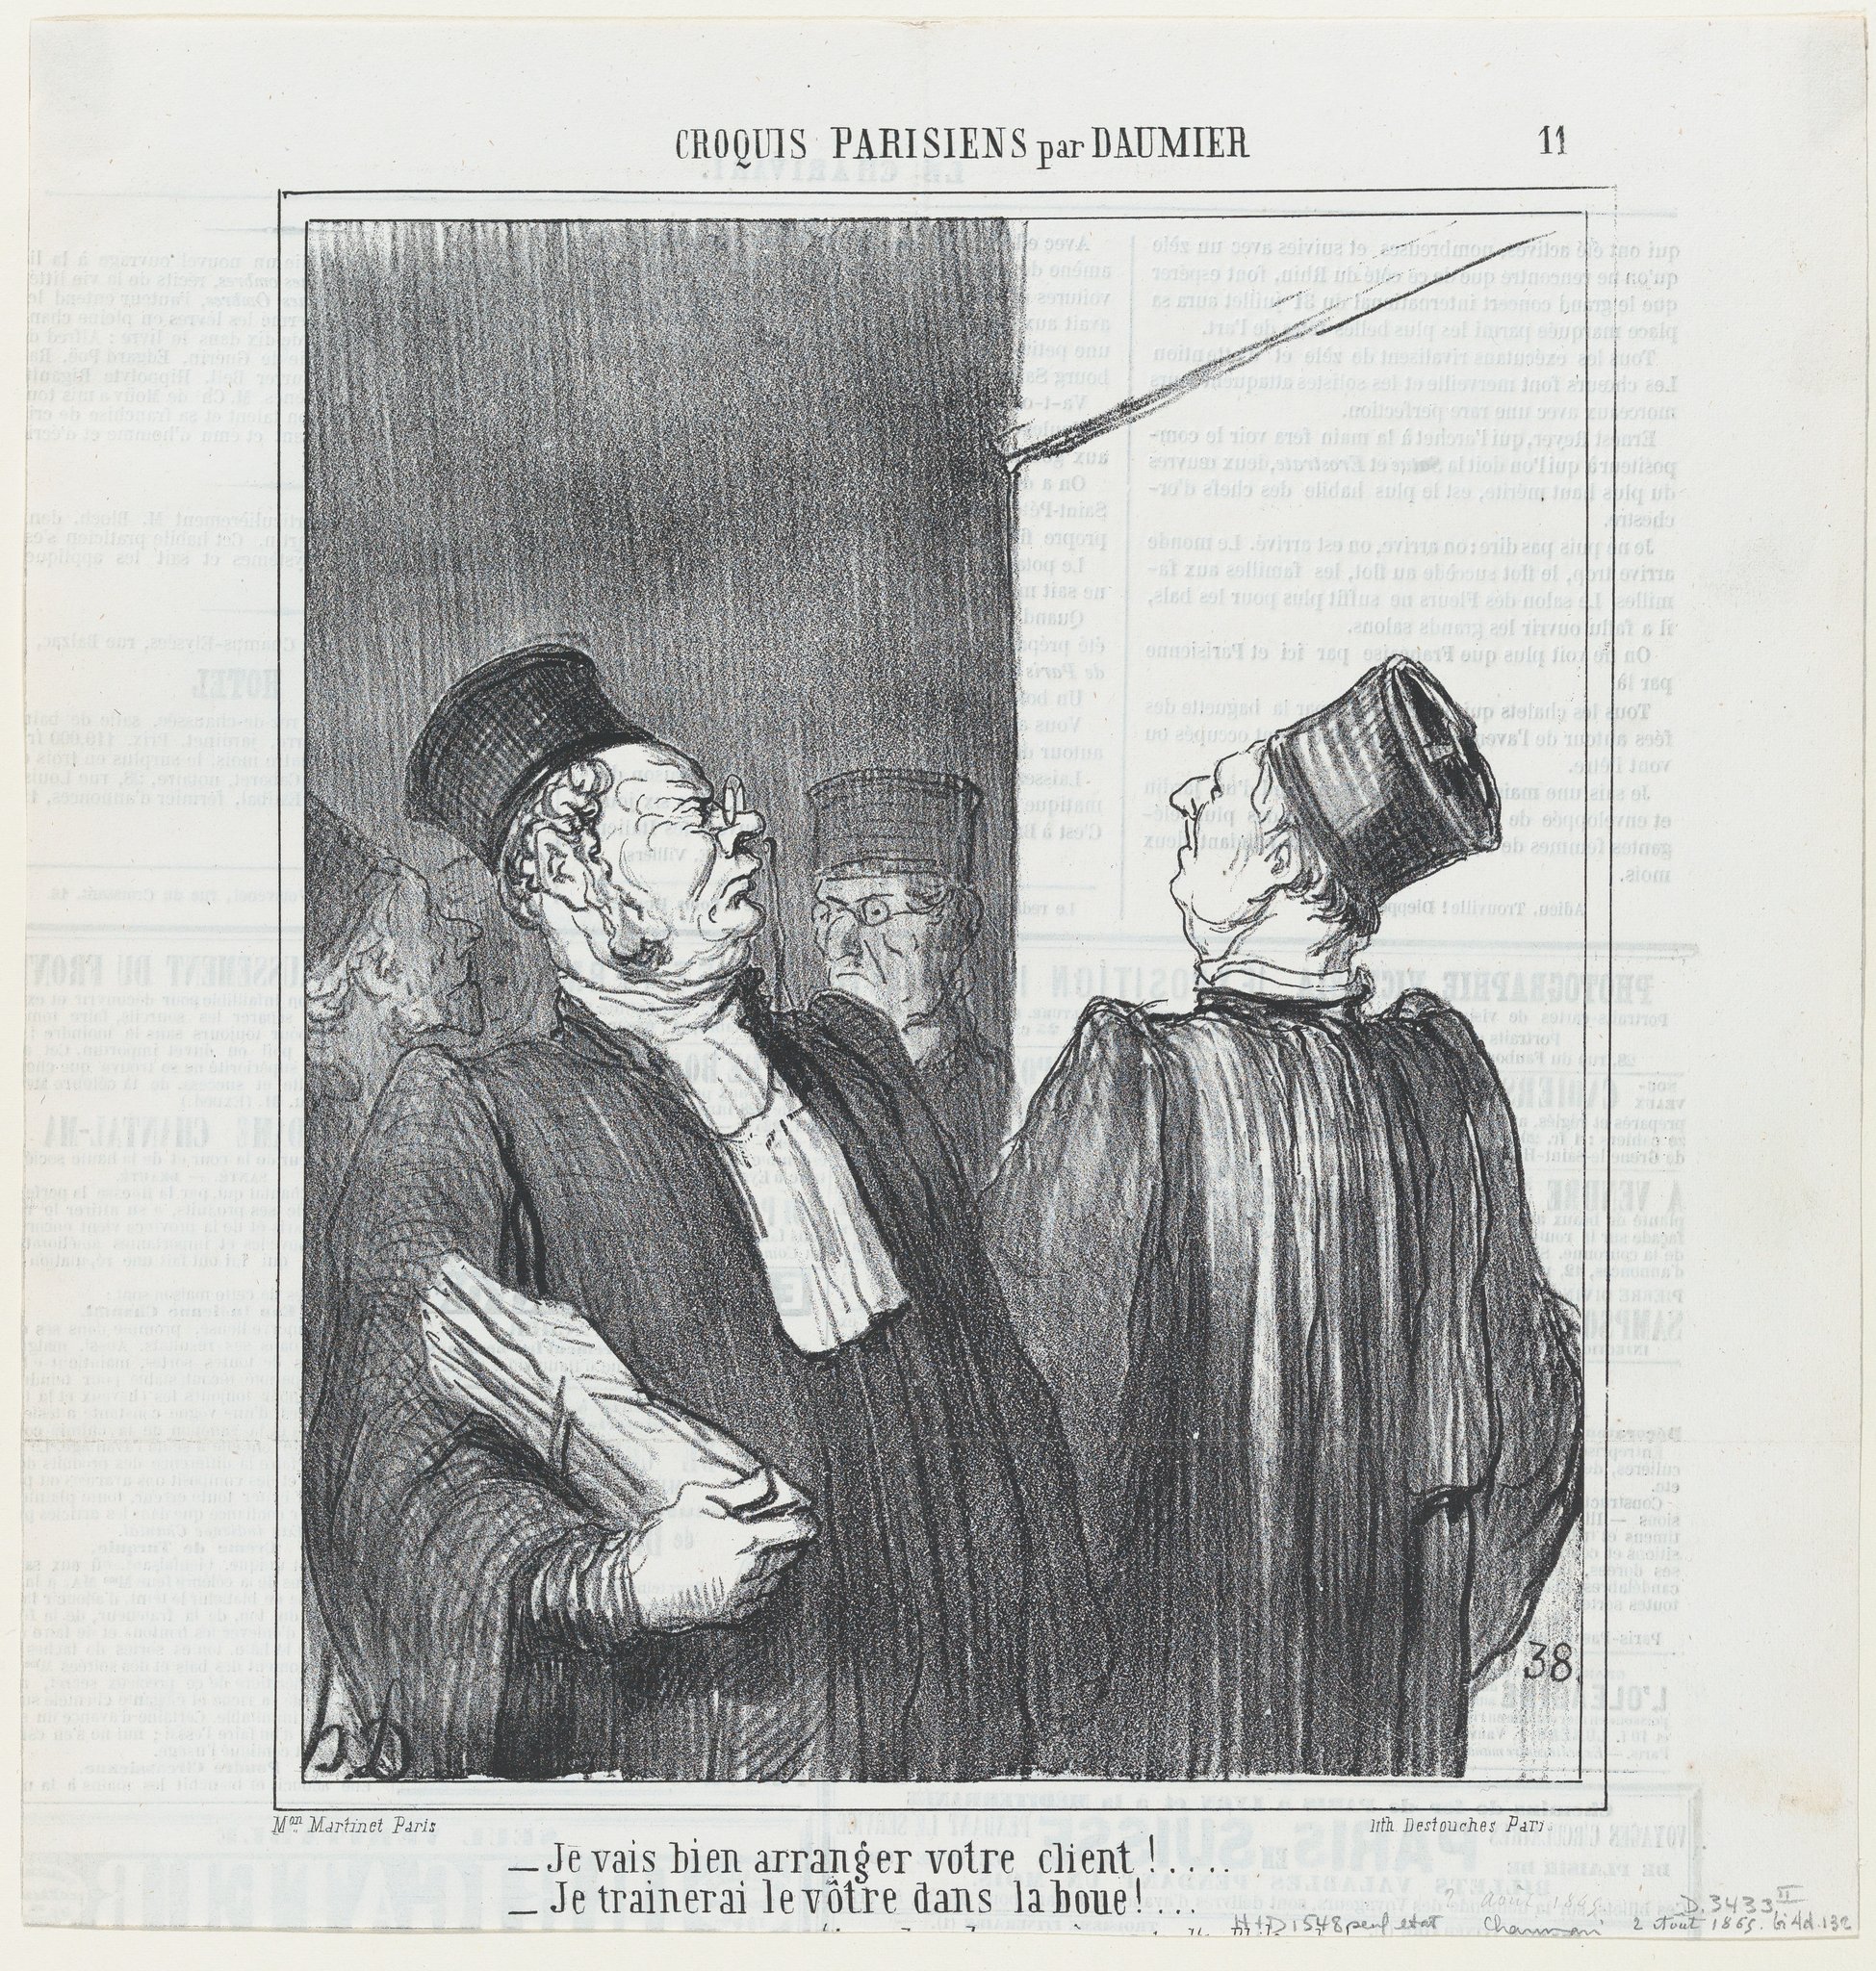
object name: print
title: I am going to compromise your client properly! I am going to drag yours through the mud!, from 'Parisian sketches,' published in Le Charivari, August 2, 1865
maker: honoré daumier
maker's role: artist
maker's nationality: french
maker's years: 1808-1879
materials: paper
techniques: lithograph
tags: men